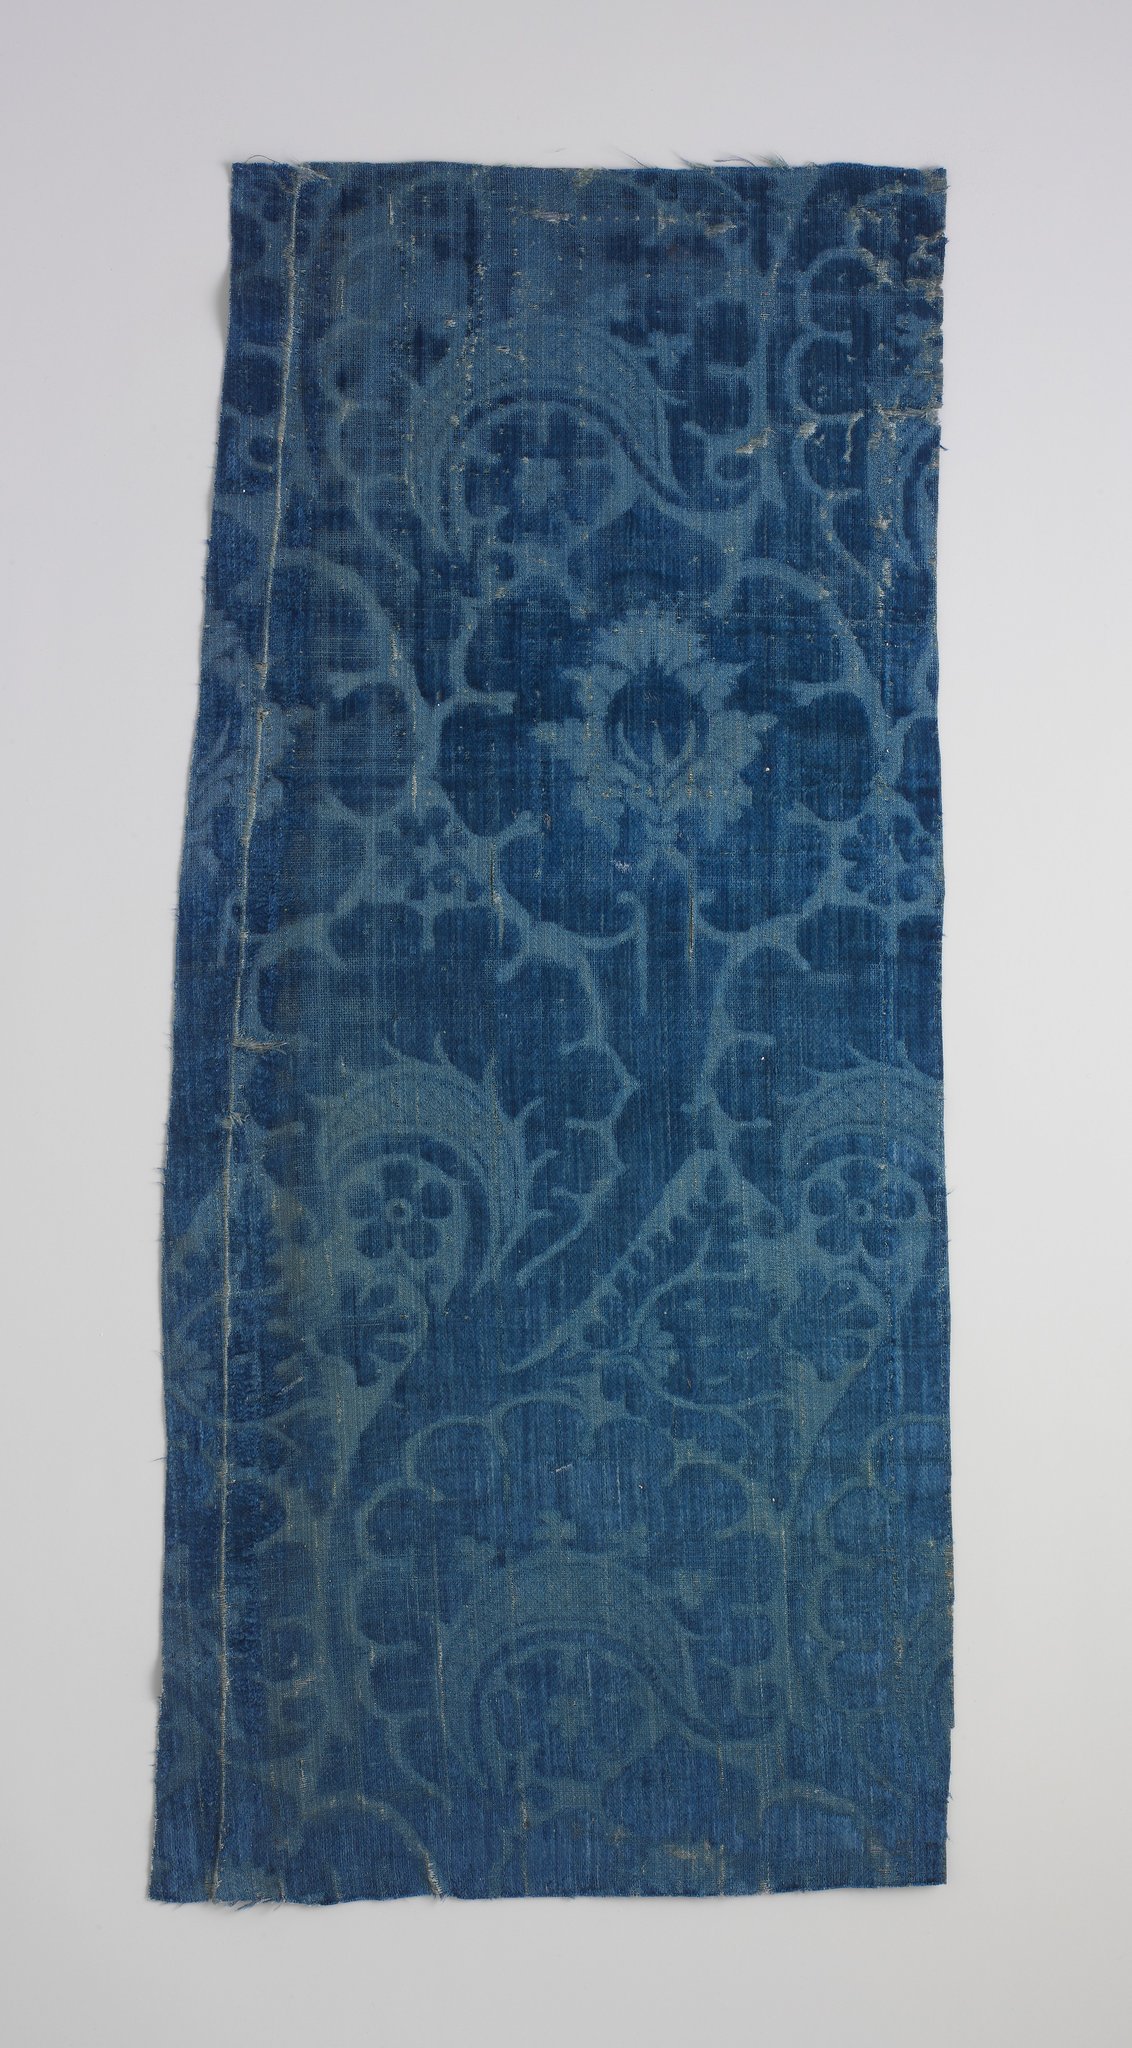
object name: piece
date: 1401-1450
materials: silk